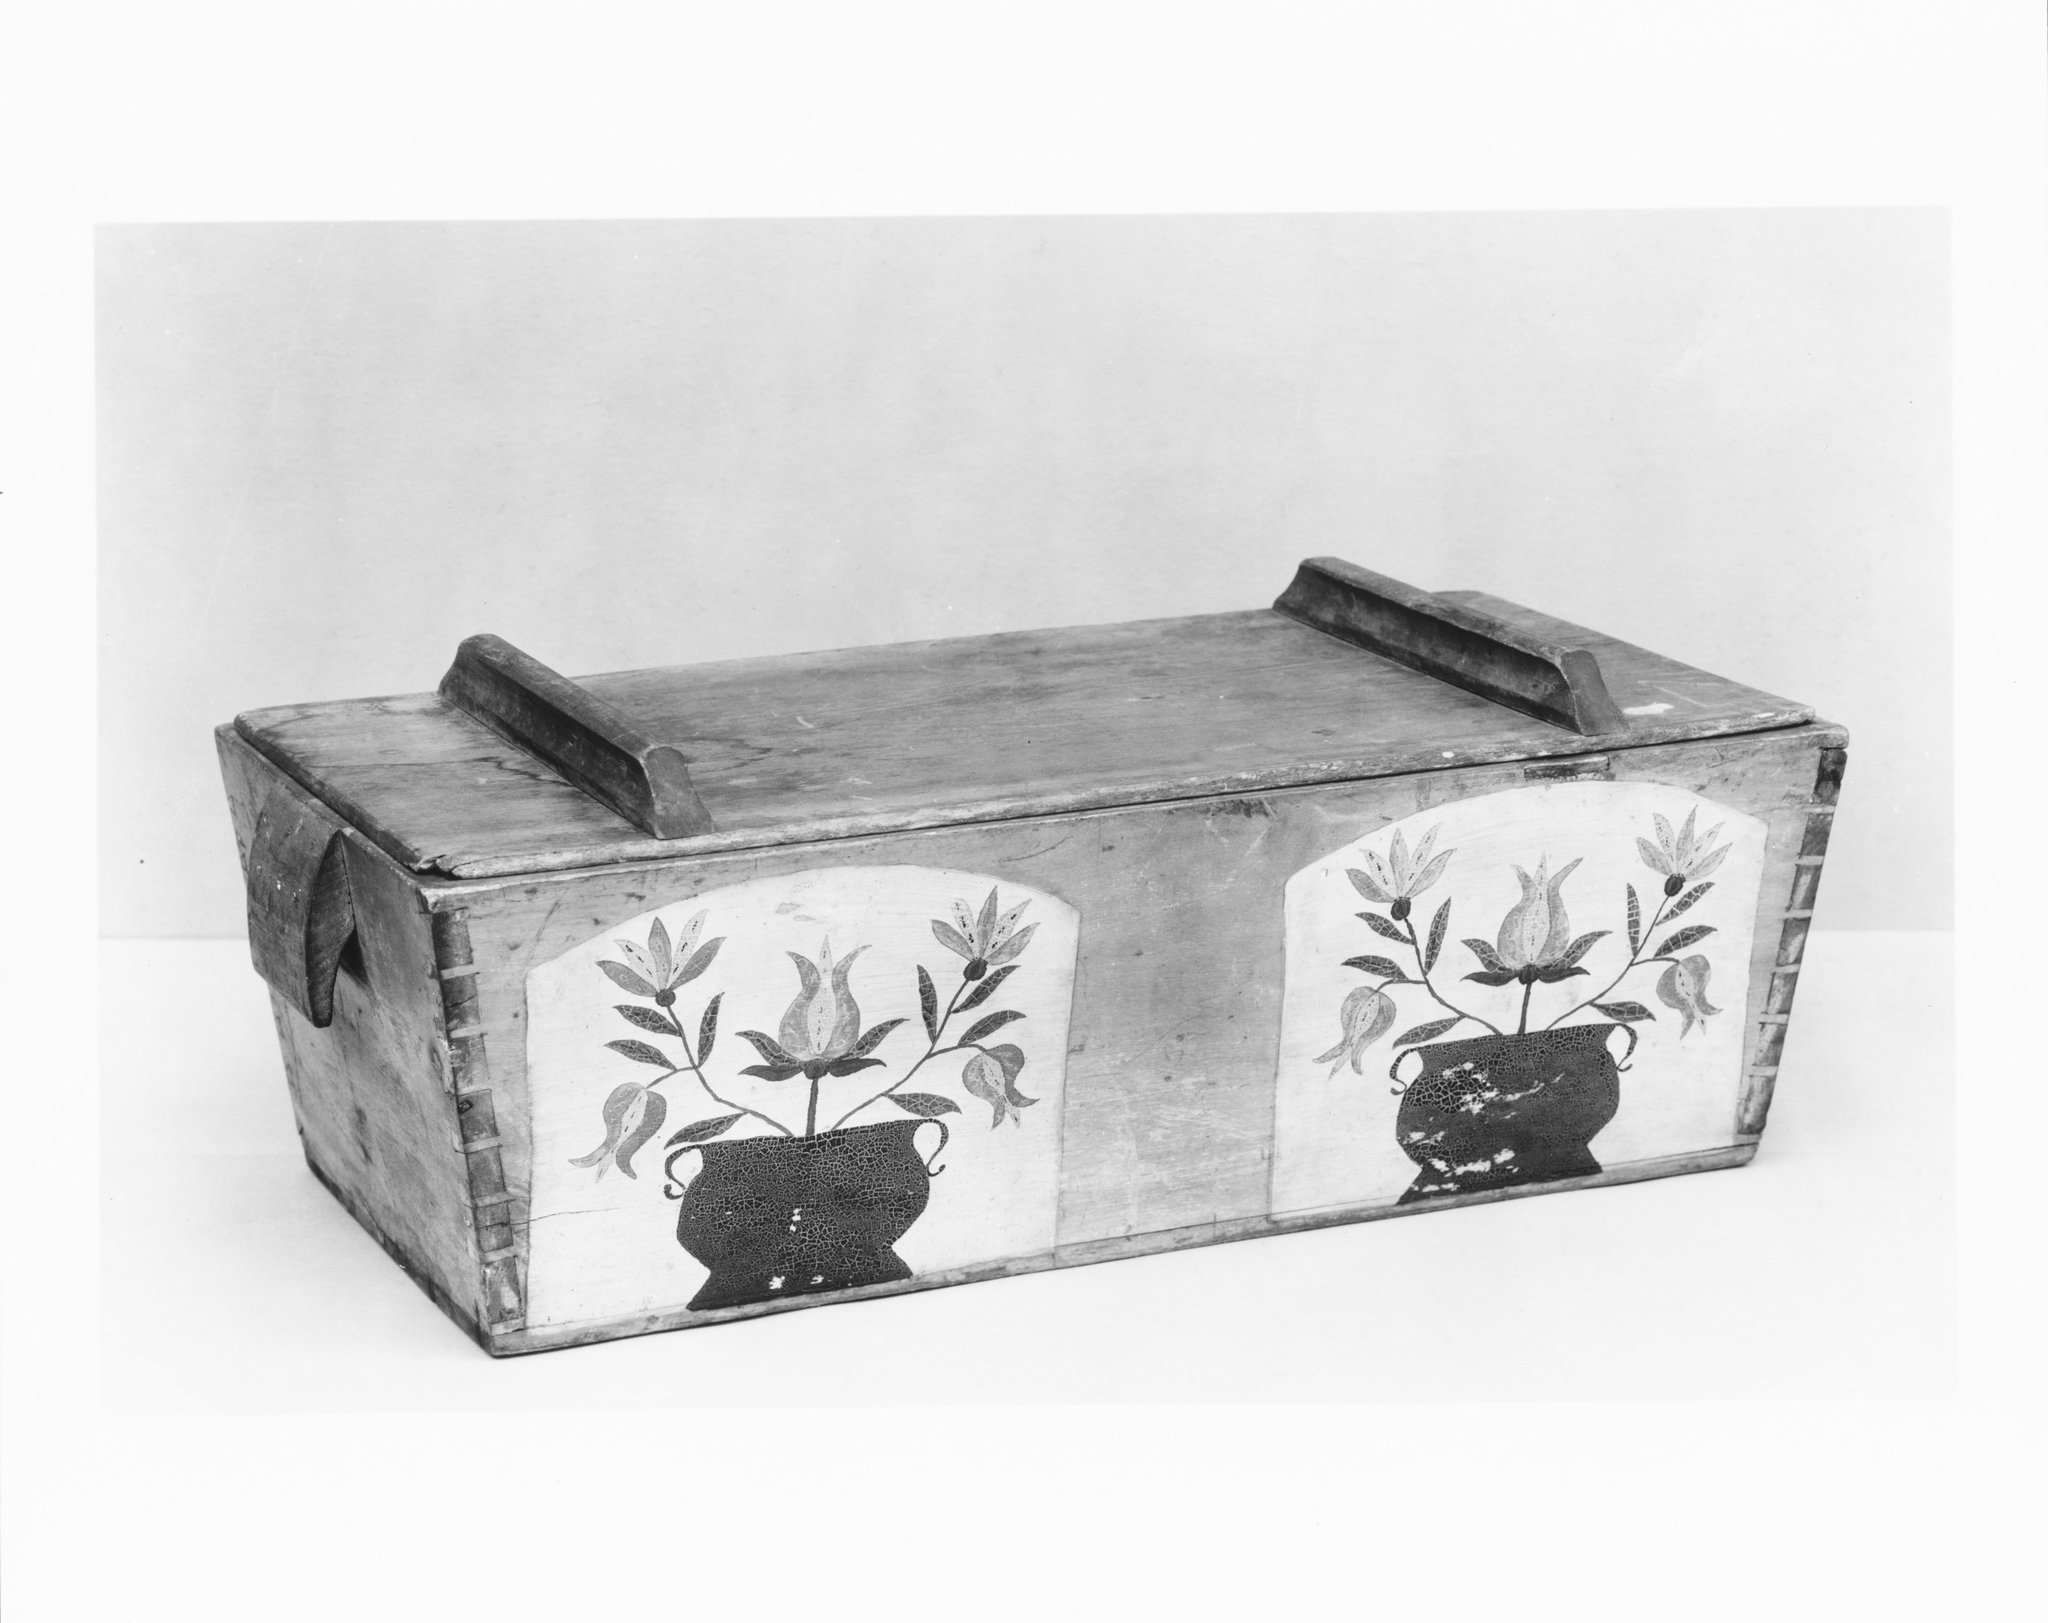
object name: box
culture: american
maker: christian selzer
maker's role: maker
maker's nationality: american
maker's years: 1777-1800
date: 1775-1820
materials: wood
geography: united states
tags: flowers